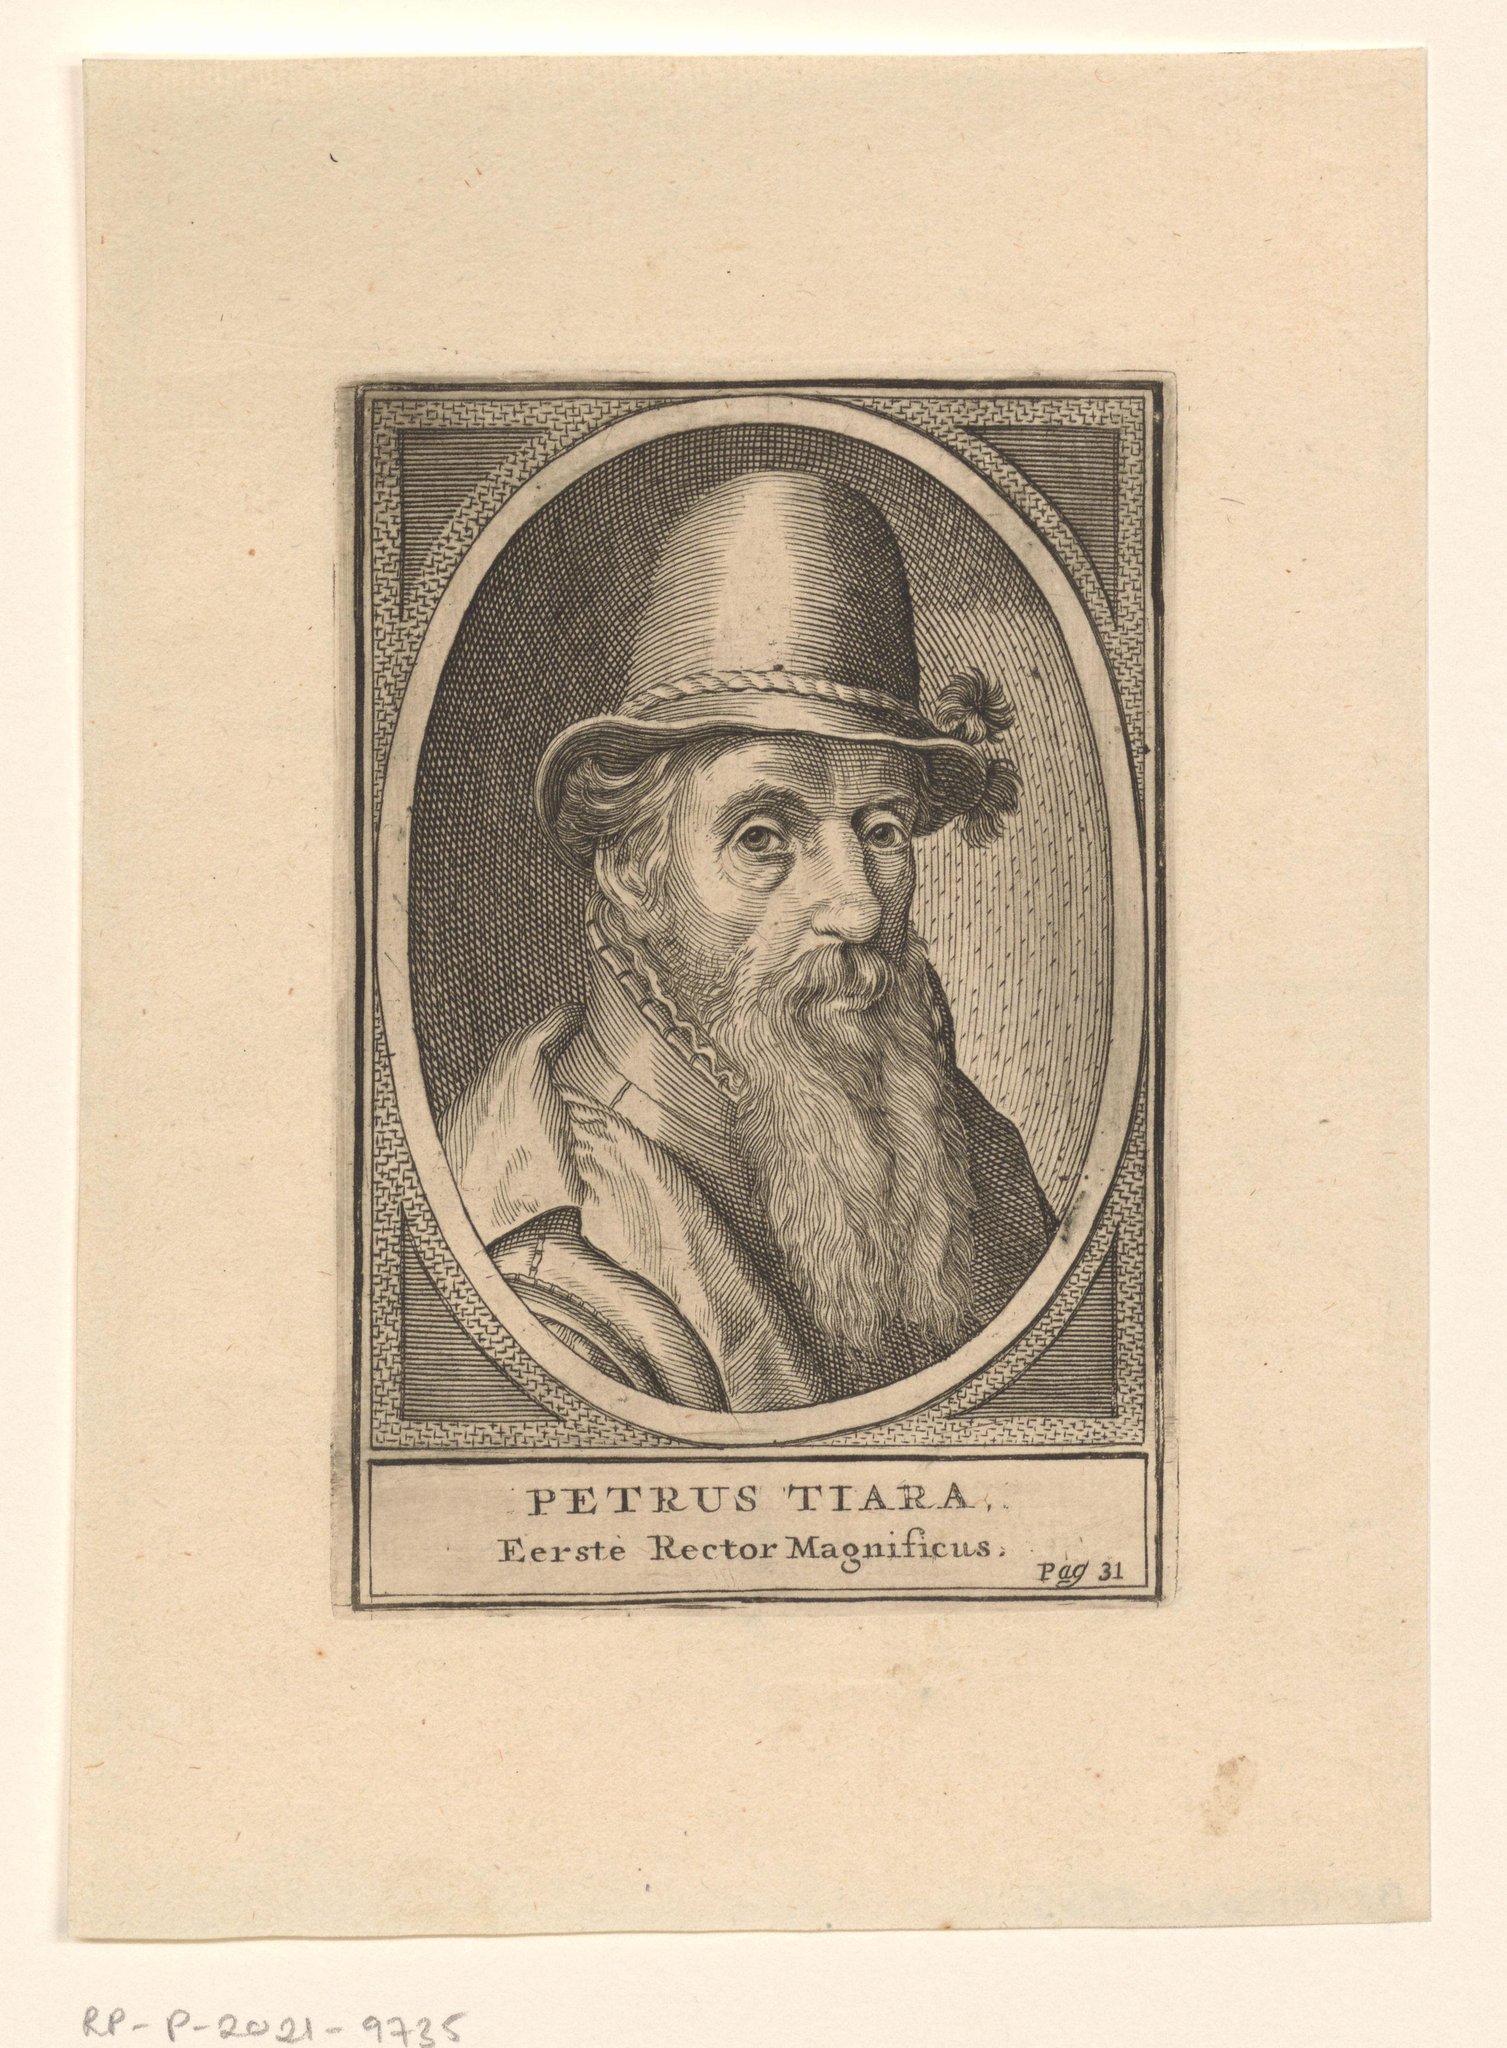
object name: print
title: Portret van Peter Tiara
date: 1614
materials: paper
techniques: engraving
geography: leiden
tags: historical persons, professor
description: Prent uit: Fabricius, Franciscus. Redenvoering over den hondert en vyftigsten verjaardag, of het derde jubeljaar der Hollandsche akademie te Leiden. Leiden: Pieter van der Aa, 1725. Eerste staat van de prent gebruikt in: Illustrium Hollandiae & Westfrisiae ordinum alma academia Leidensis. Leiden: Jacob Marcus en Joost van Colster, 1614.